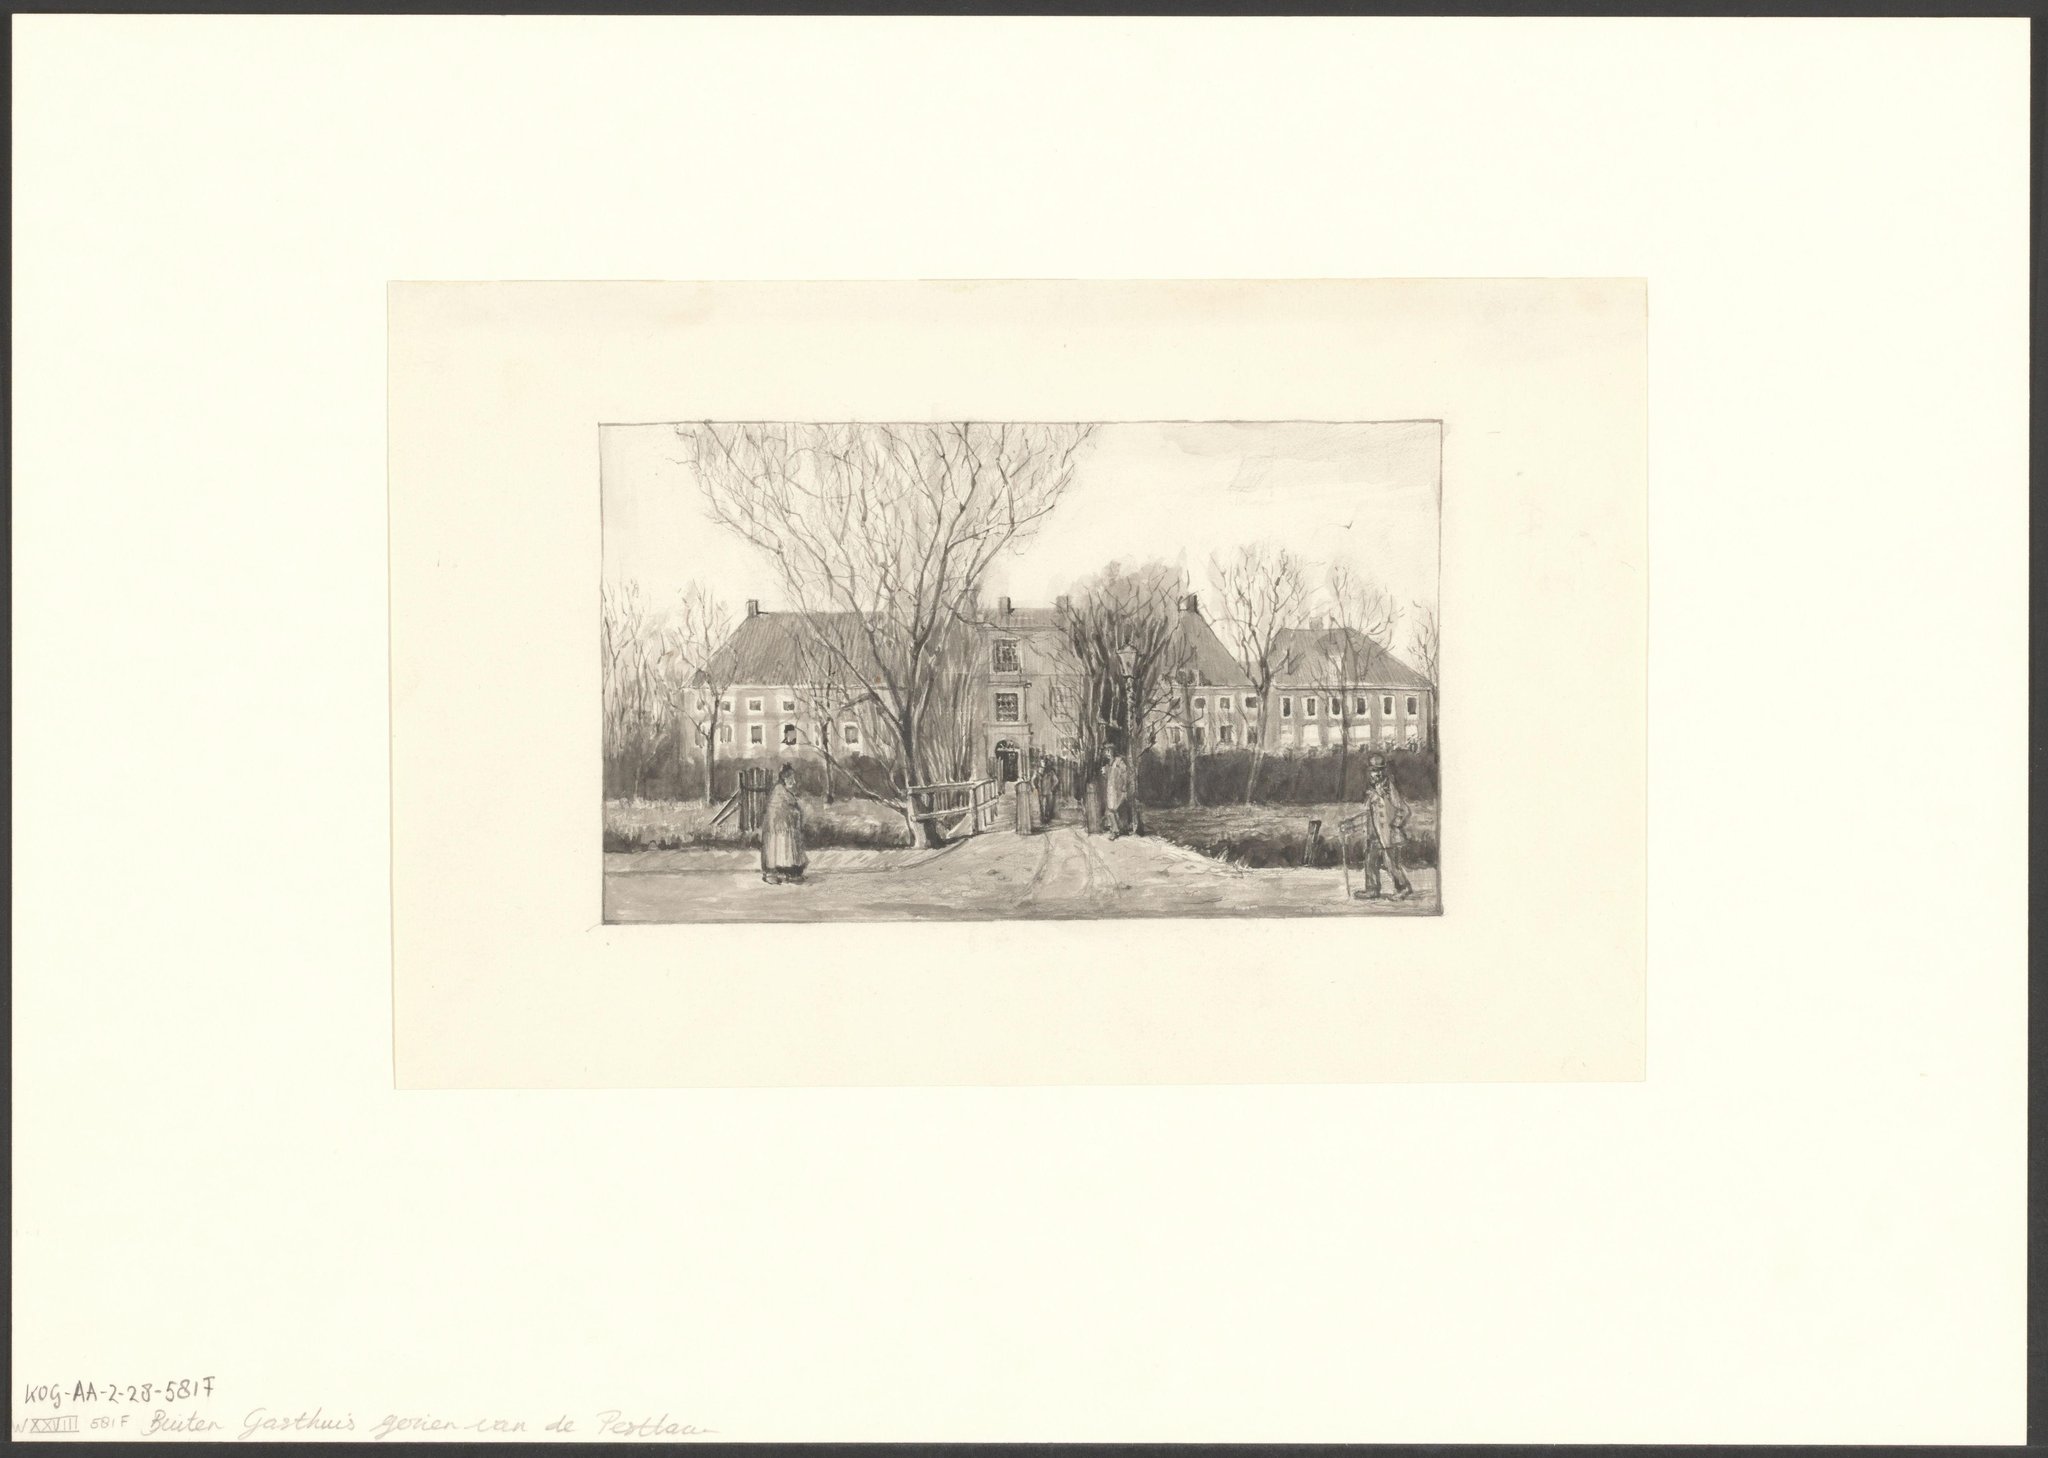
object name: drawing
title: Gezicht op het Buitengasthuis aan de Overtoom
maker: goedkoop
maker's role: draughtsman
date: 1850-1950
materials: ink, paper, pencil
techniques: brush, pen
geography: amsterdam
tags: city-view in general; 'veduta', façade (of house or building)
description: Tekening binnen de Atlas Van Eck ingedeeld op wijknummer 28.